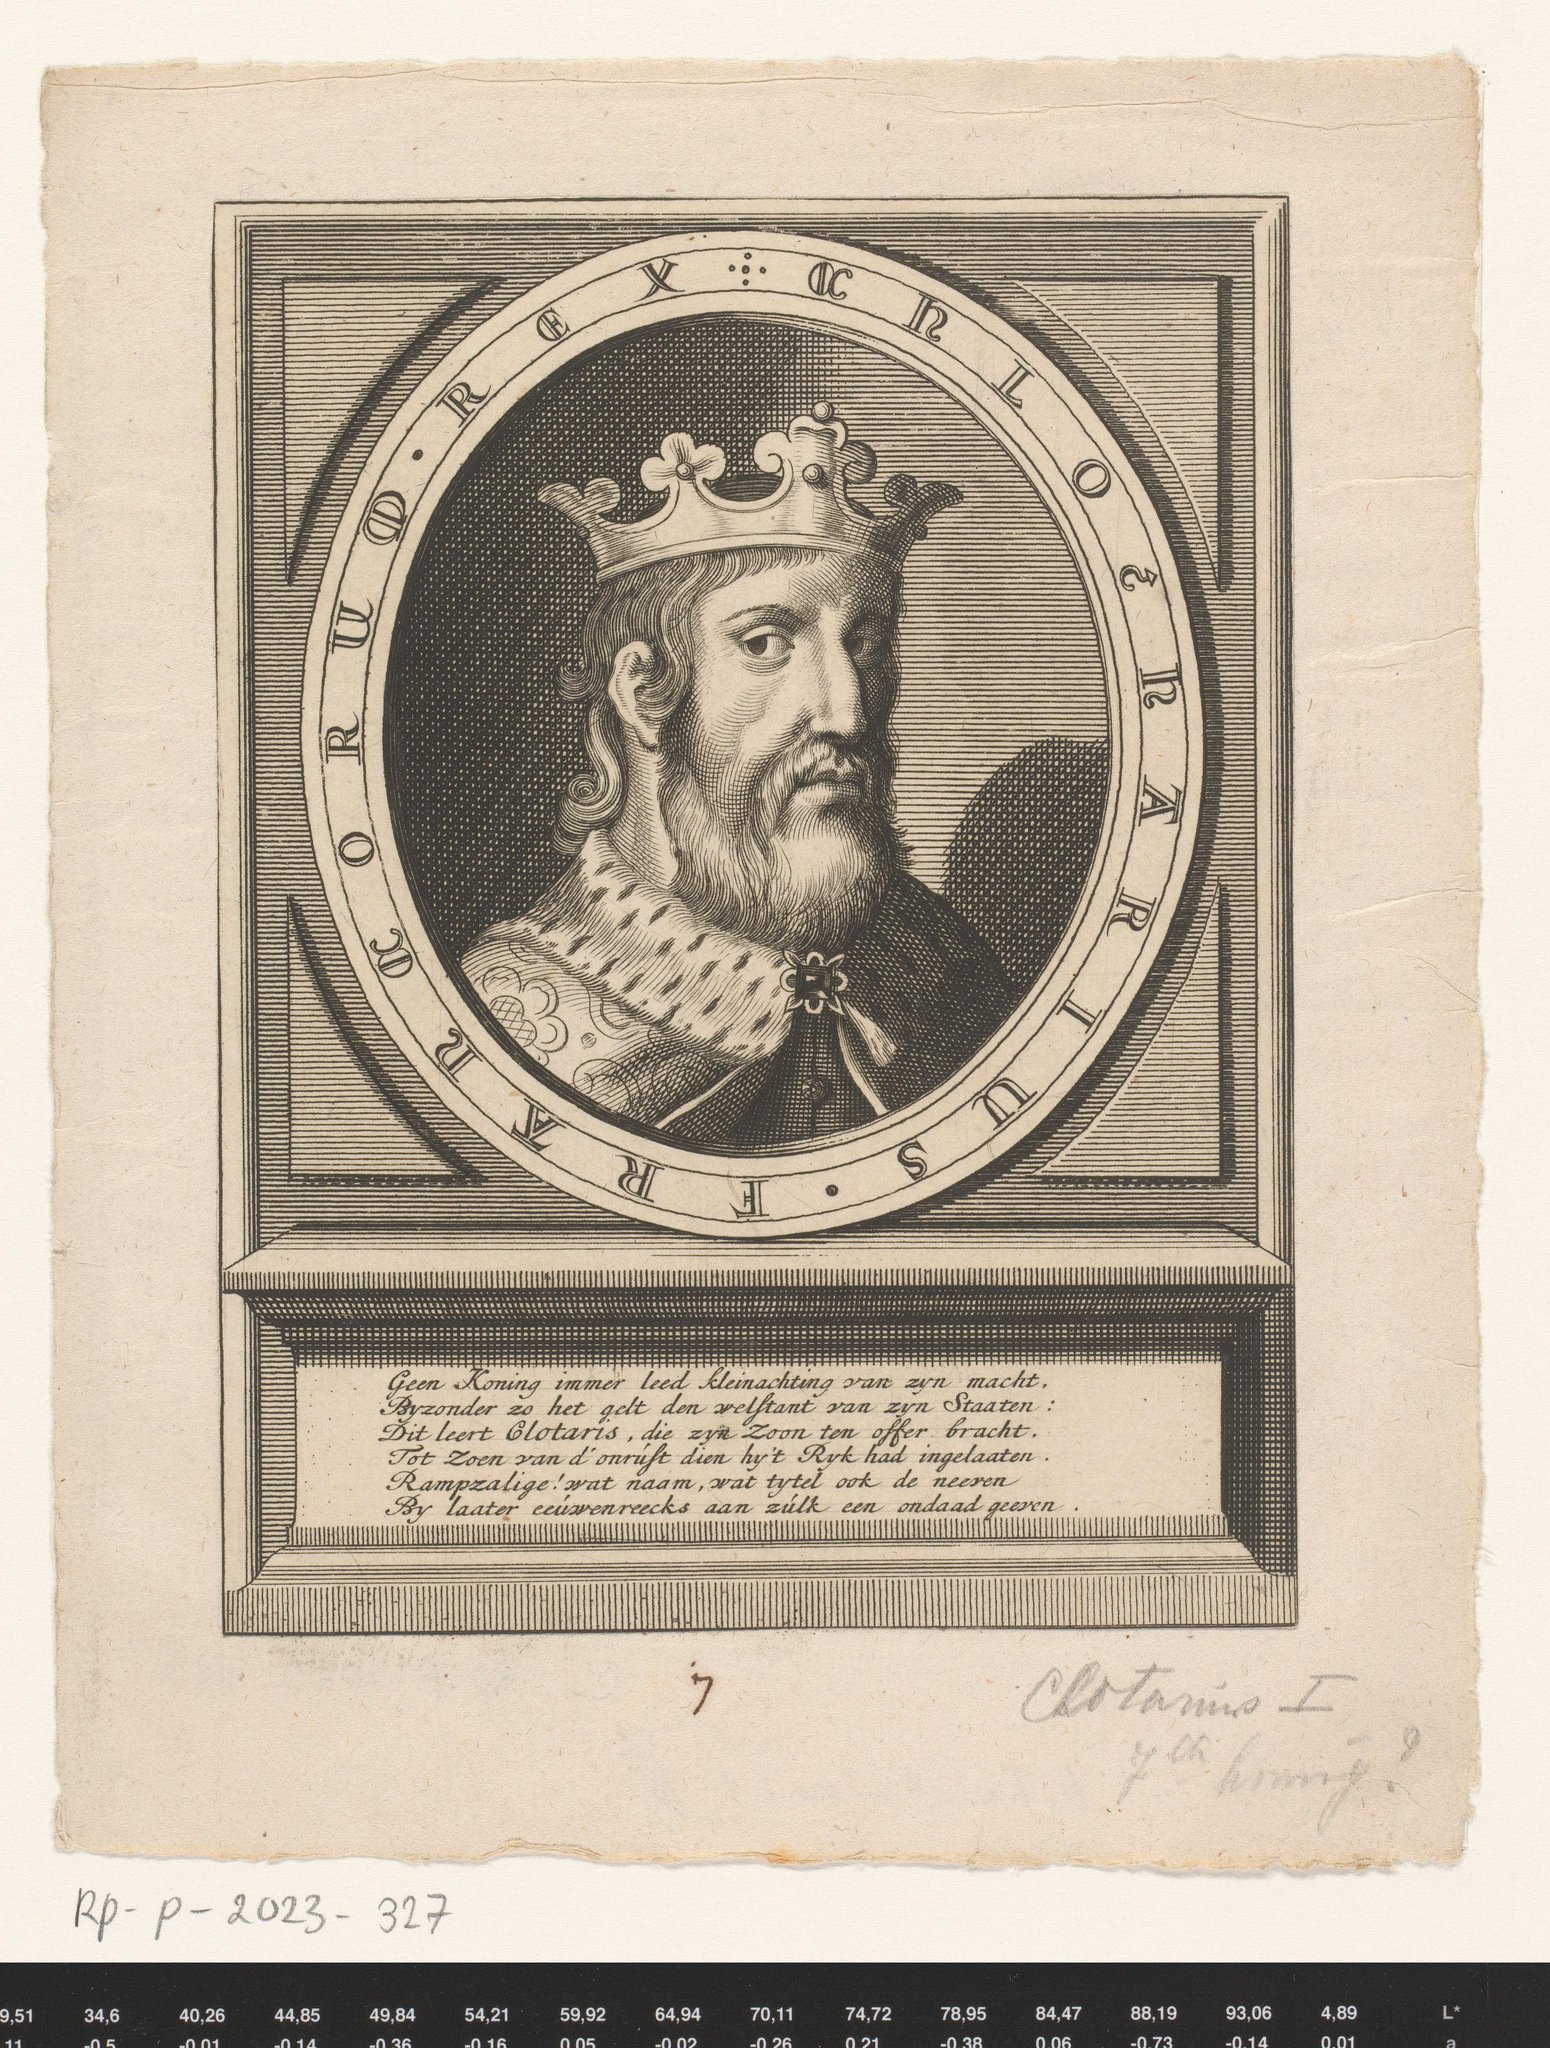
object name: print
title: Portret van Chlotharius I, koning der Franken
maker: Anonymous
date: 1685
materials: paper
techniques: engraving, etching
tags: historical persons, king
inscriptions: collector's mark: Lugt 2228, number: ‘7’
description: Prent waarschijnlijk uit: Mézeray, François Eudes de. Chronyk van Vrankryk. [Vertaald uit het Frans door] G. v. Broekhuizen. Amsterdam: Timotheus ten Hoorn en Jan Bouman, 1685, dl. 1, p. 55.